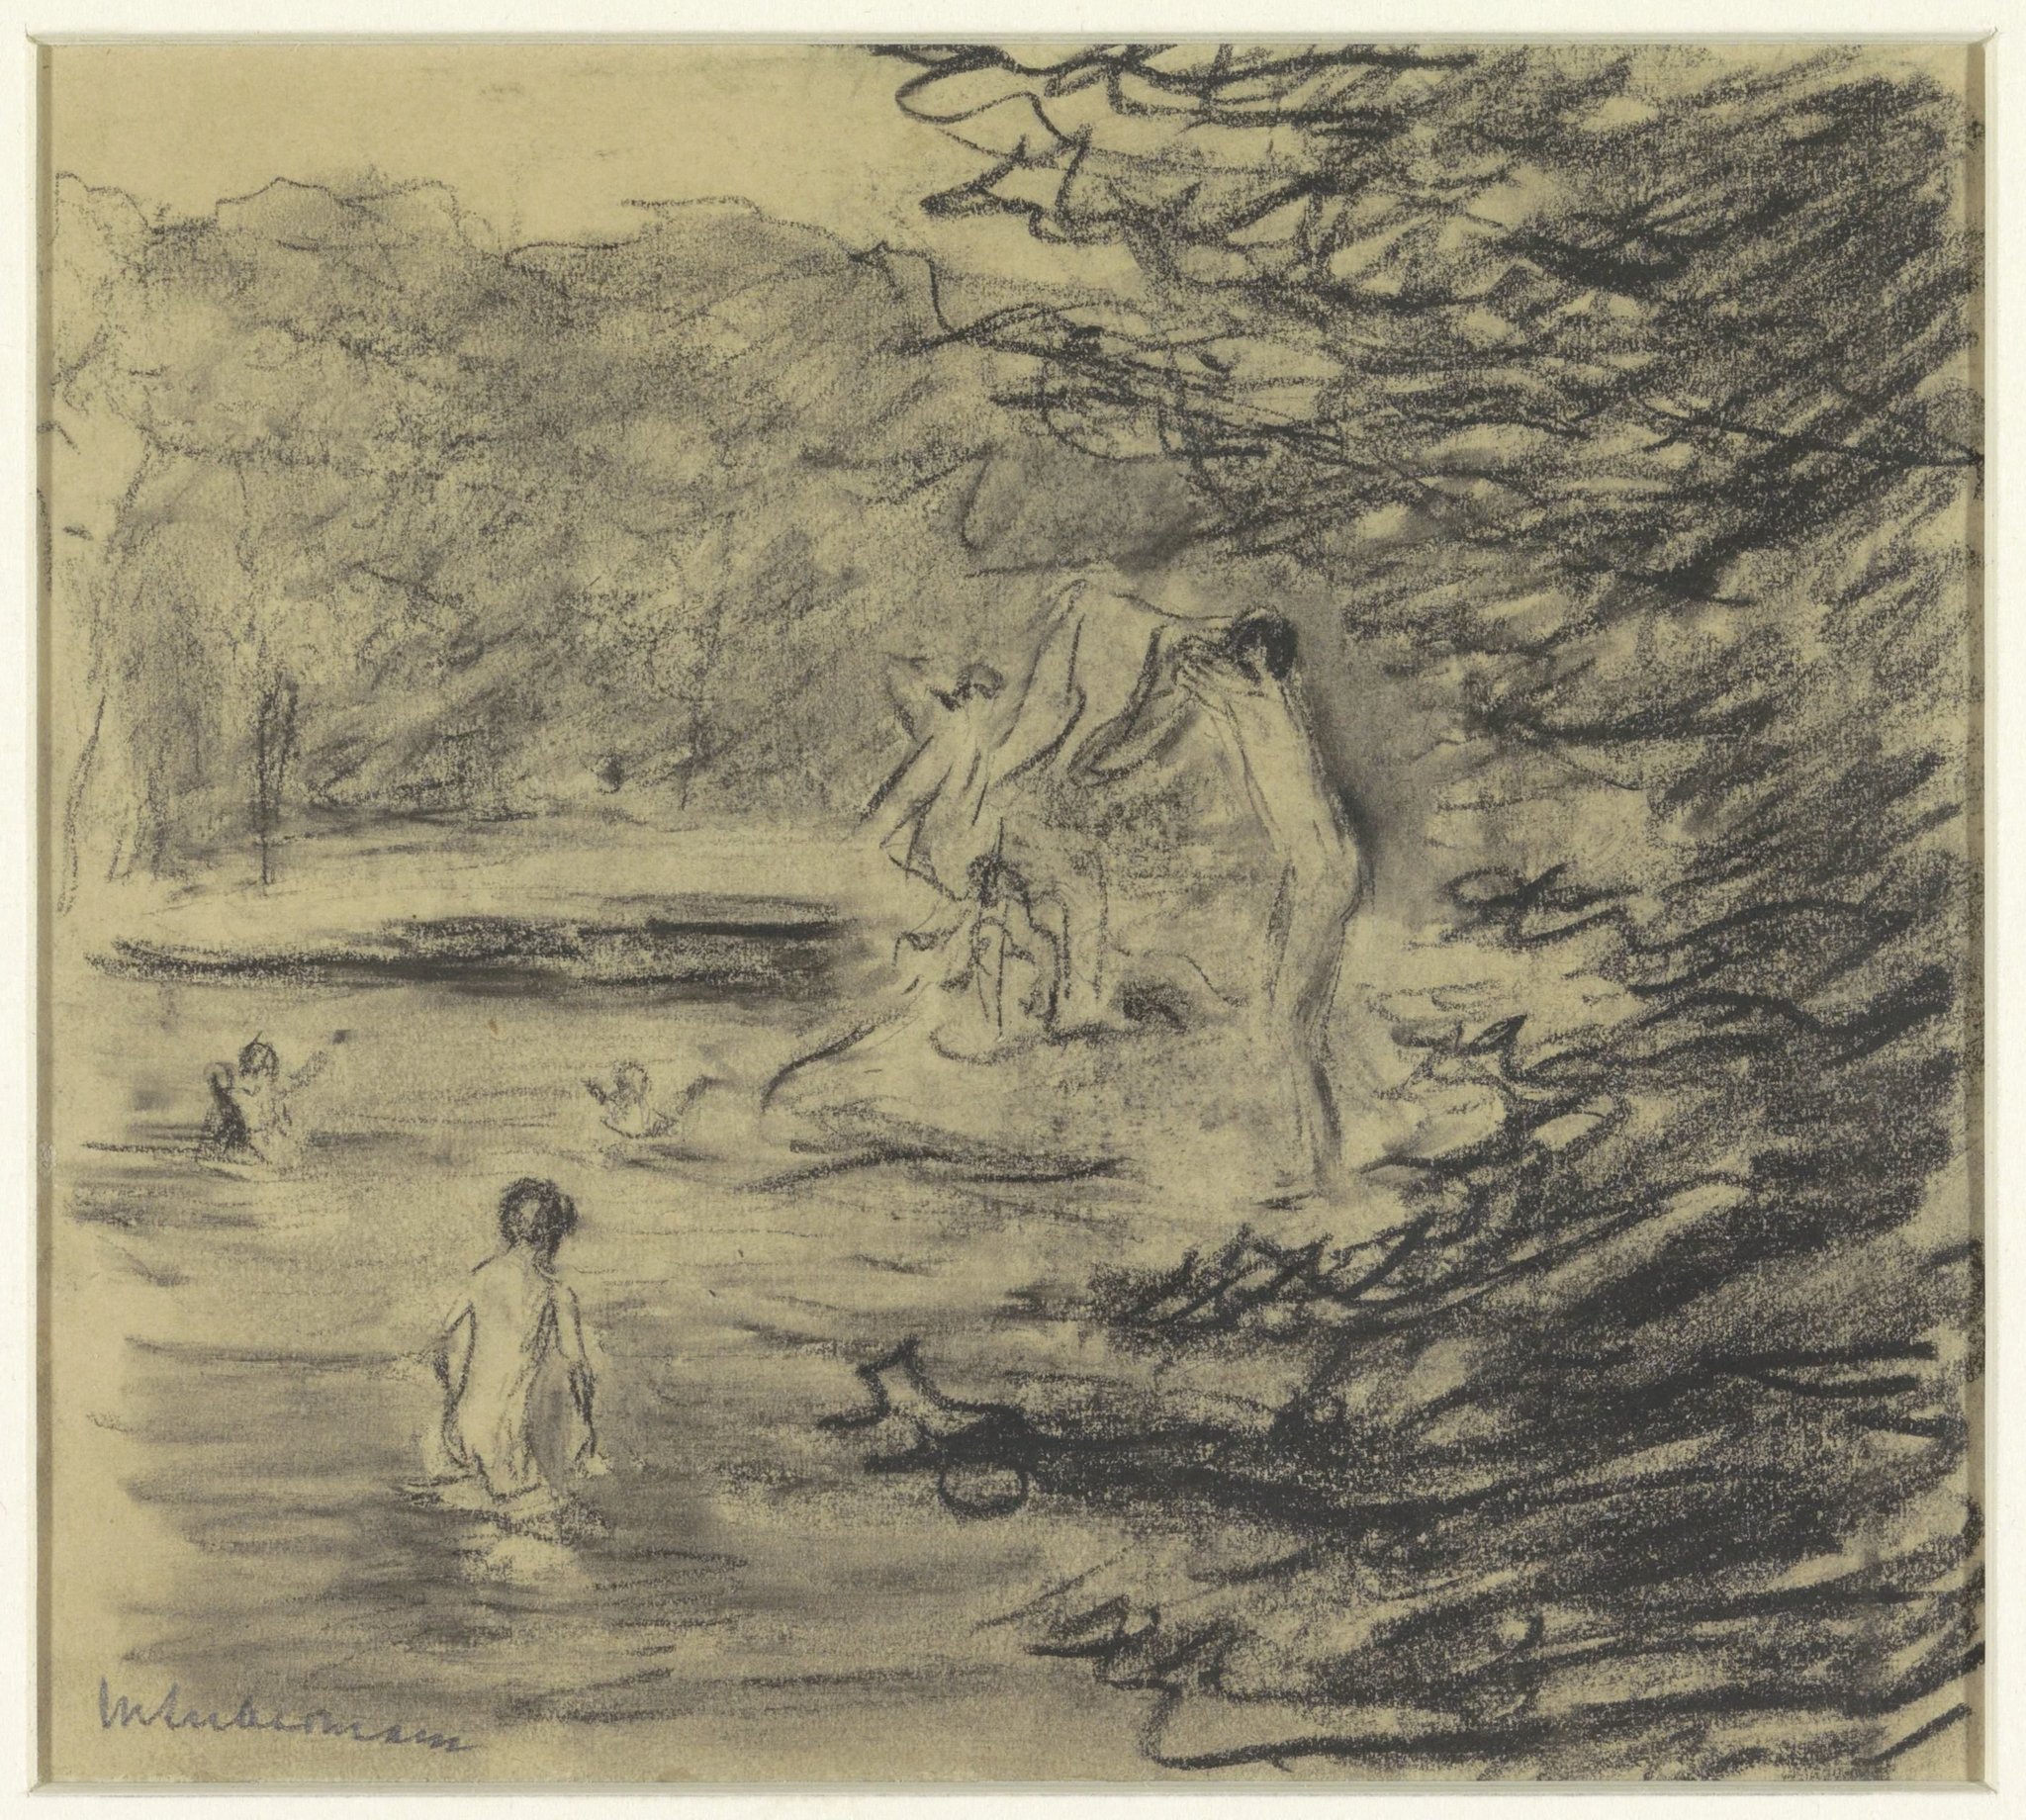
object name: drawing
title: Badende jongens in bosvijver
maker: max liebermann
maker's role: draughtsman, print maker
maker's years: 1847-1935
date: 1857-1935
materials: chalk, paper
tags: public baths - aa - in the open air